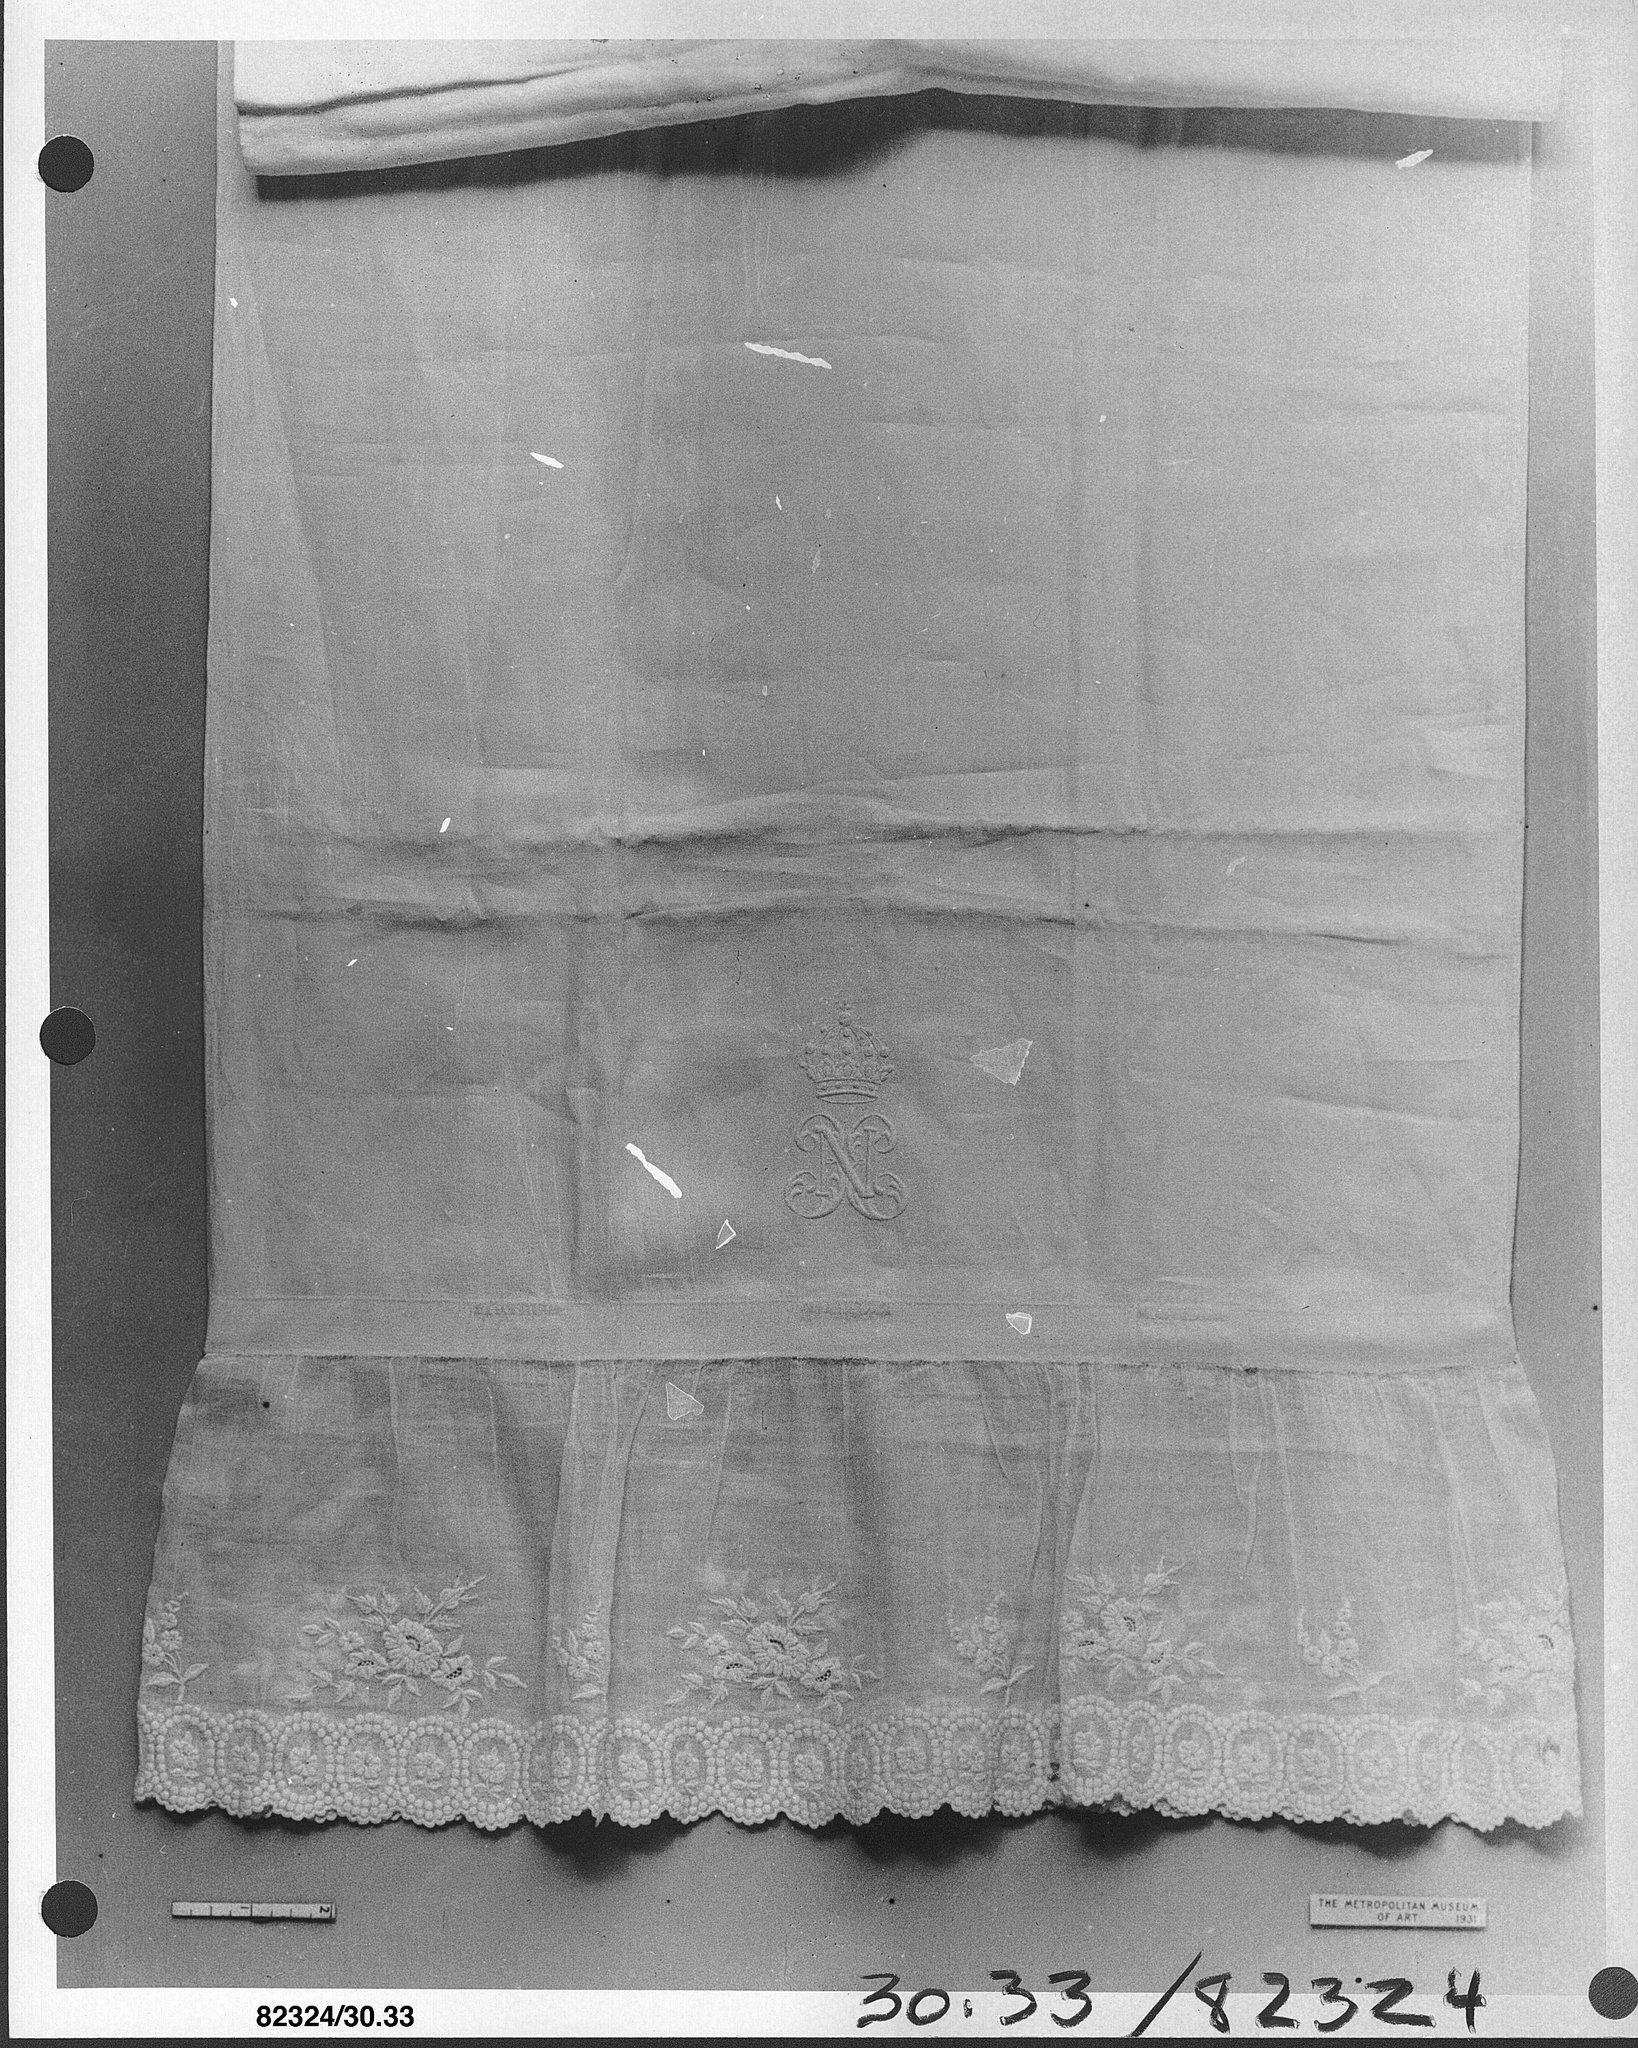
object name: pillowcase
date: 1801-1900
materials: linen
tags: flowers